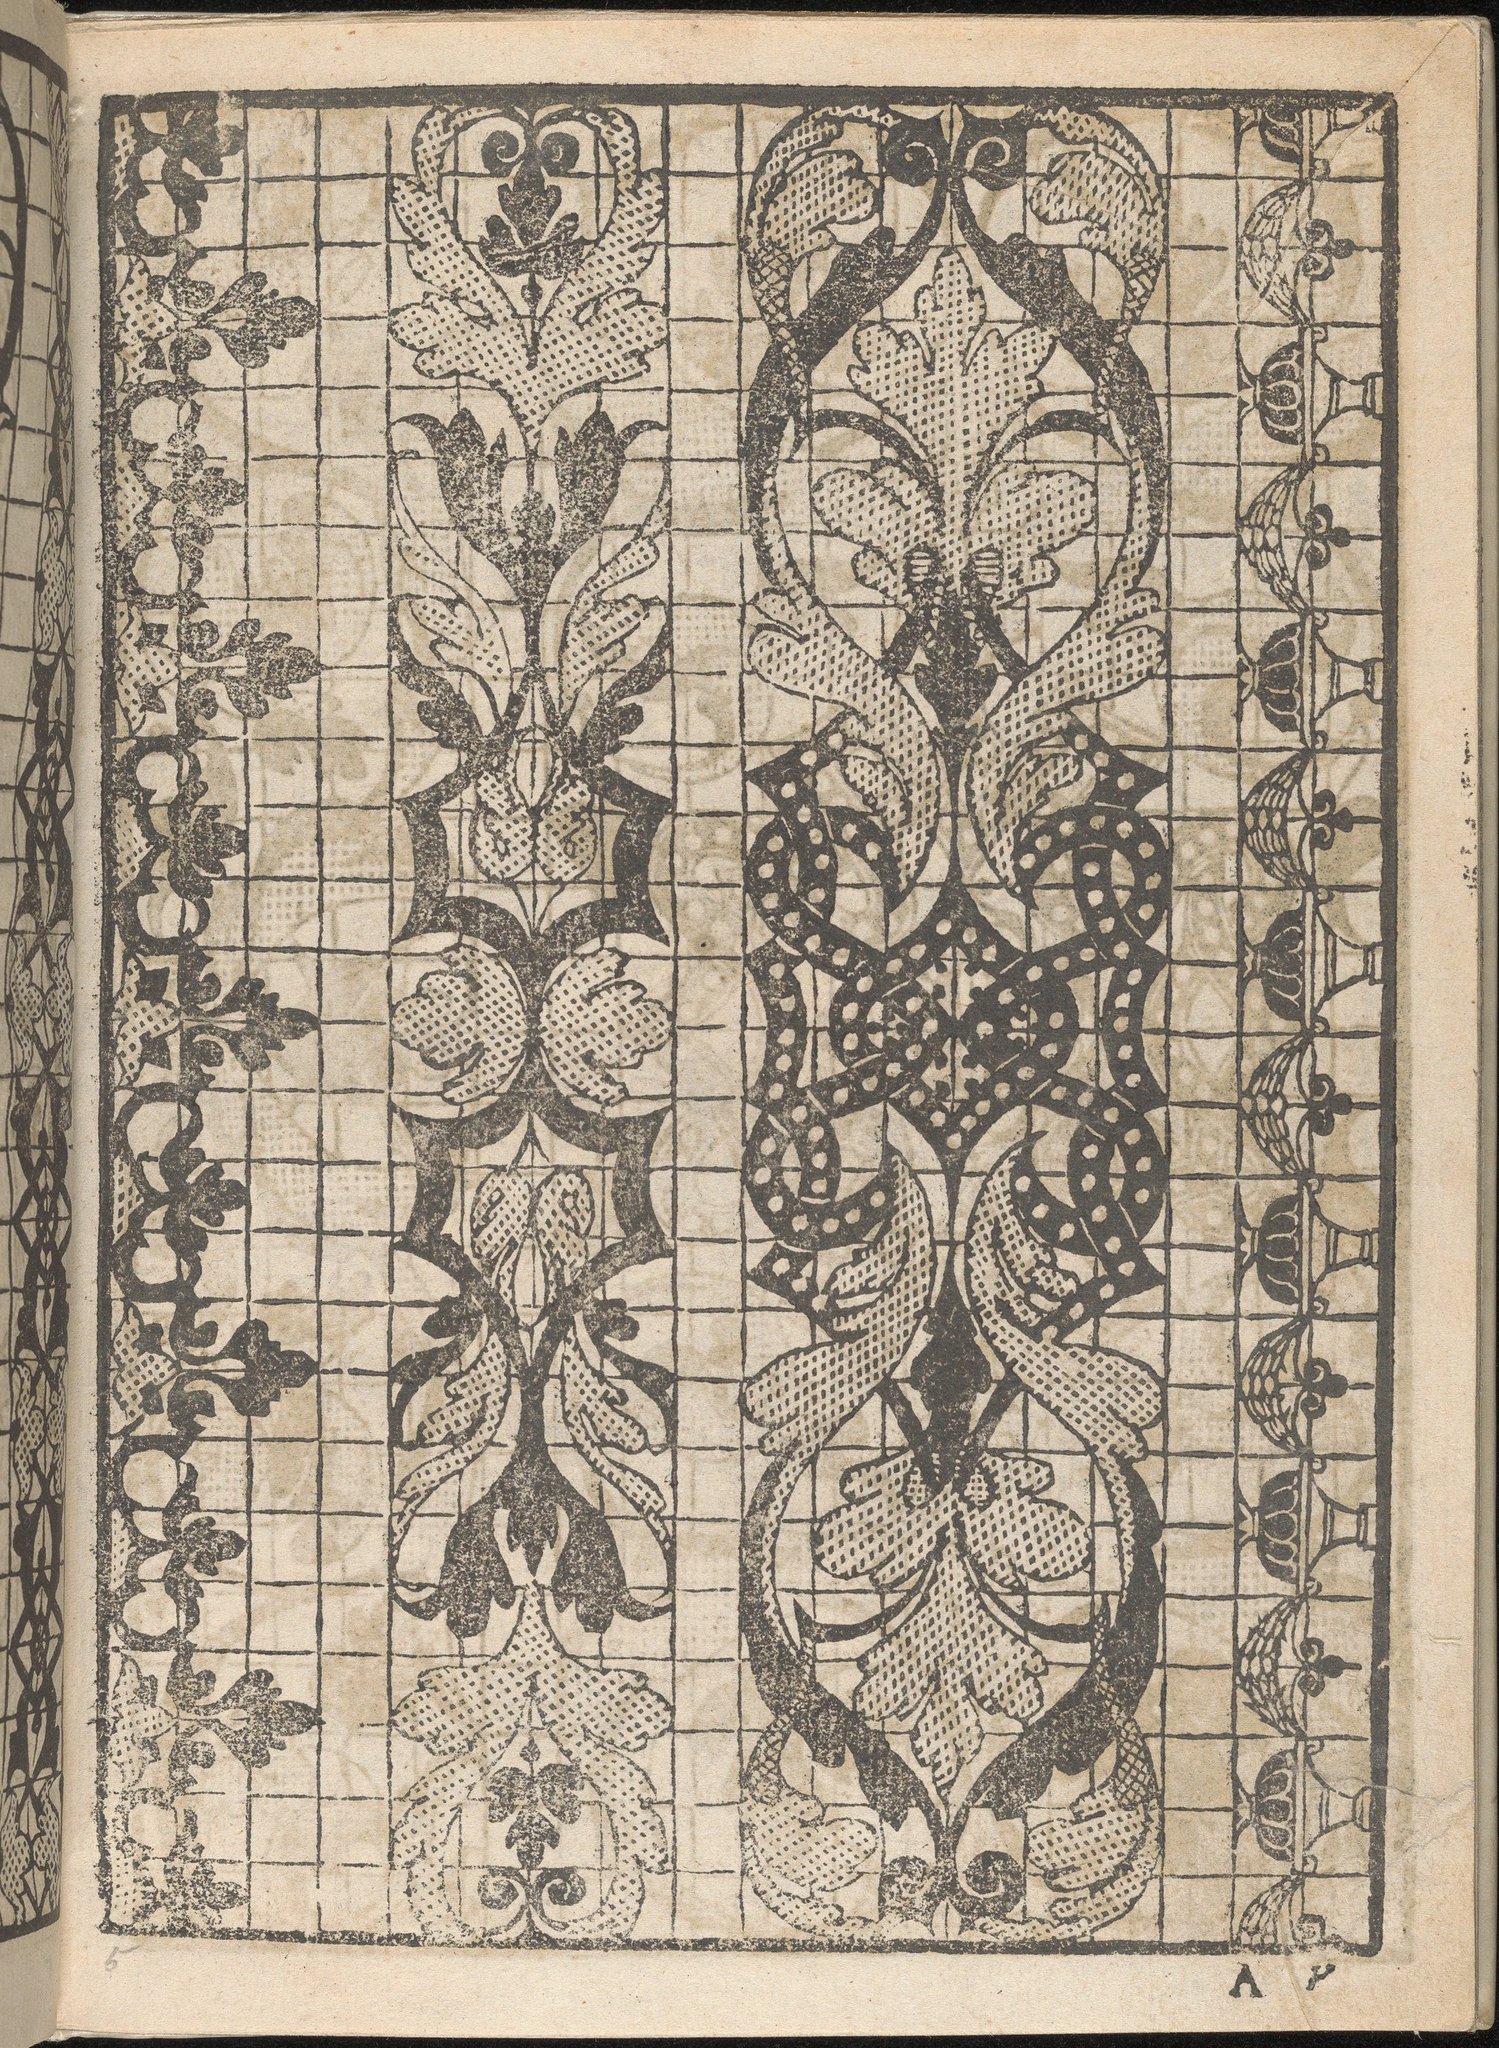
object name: book print ornament architecture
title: Splendore delle virtuose giovani, page 3 (recto)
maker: iseppo foresto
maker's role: designer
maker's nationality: italian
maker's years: 1520-1580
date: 1564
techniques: woodcut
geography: italy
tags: vines